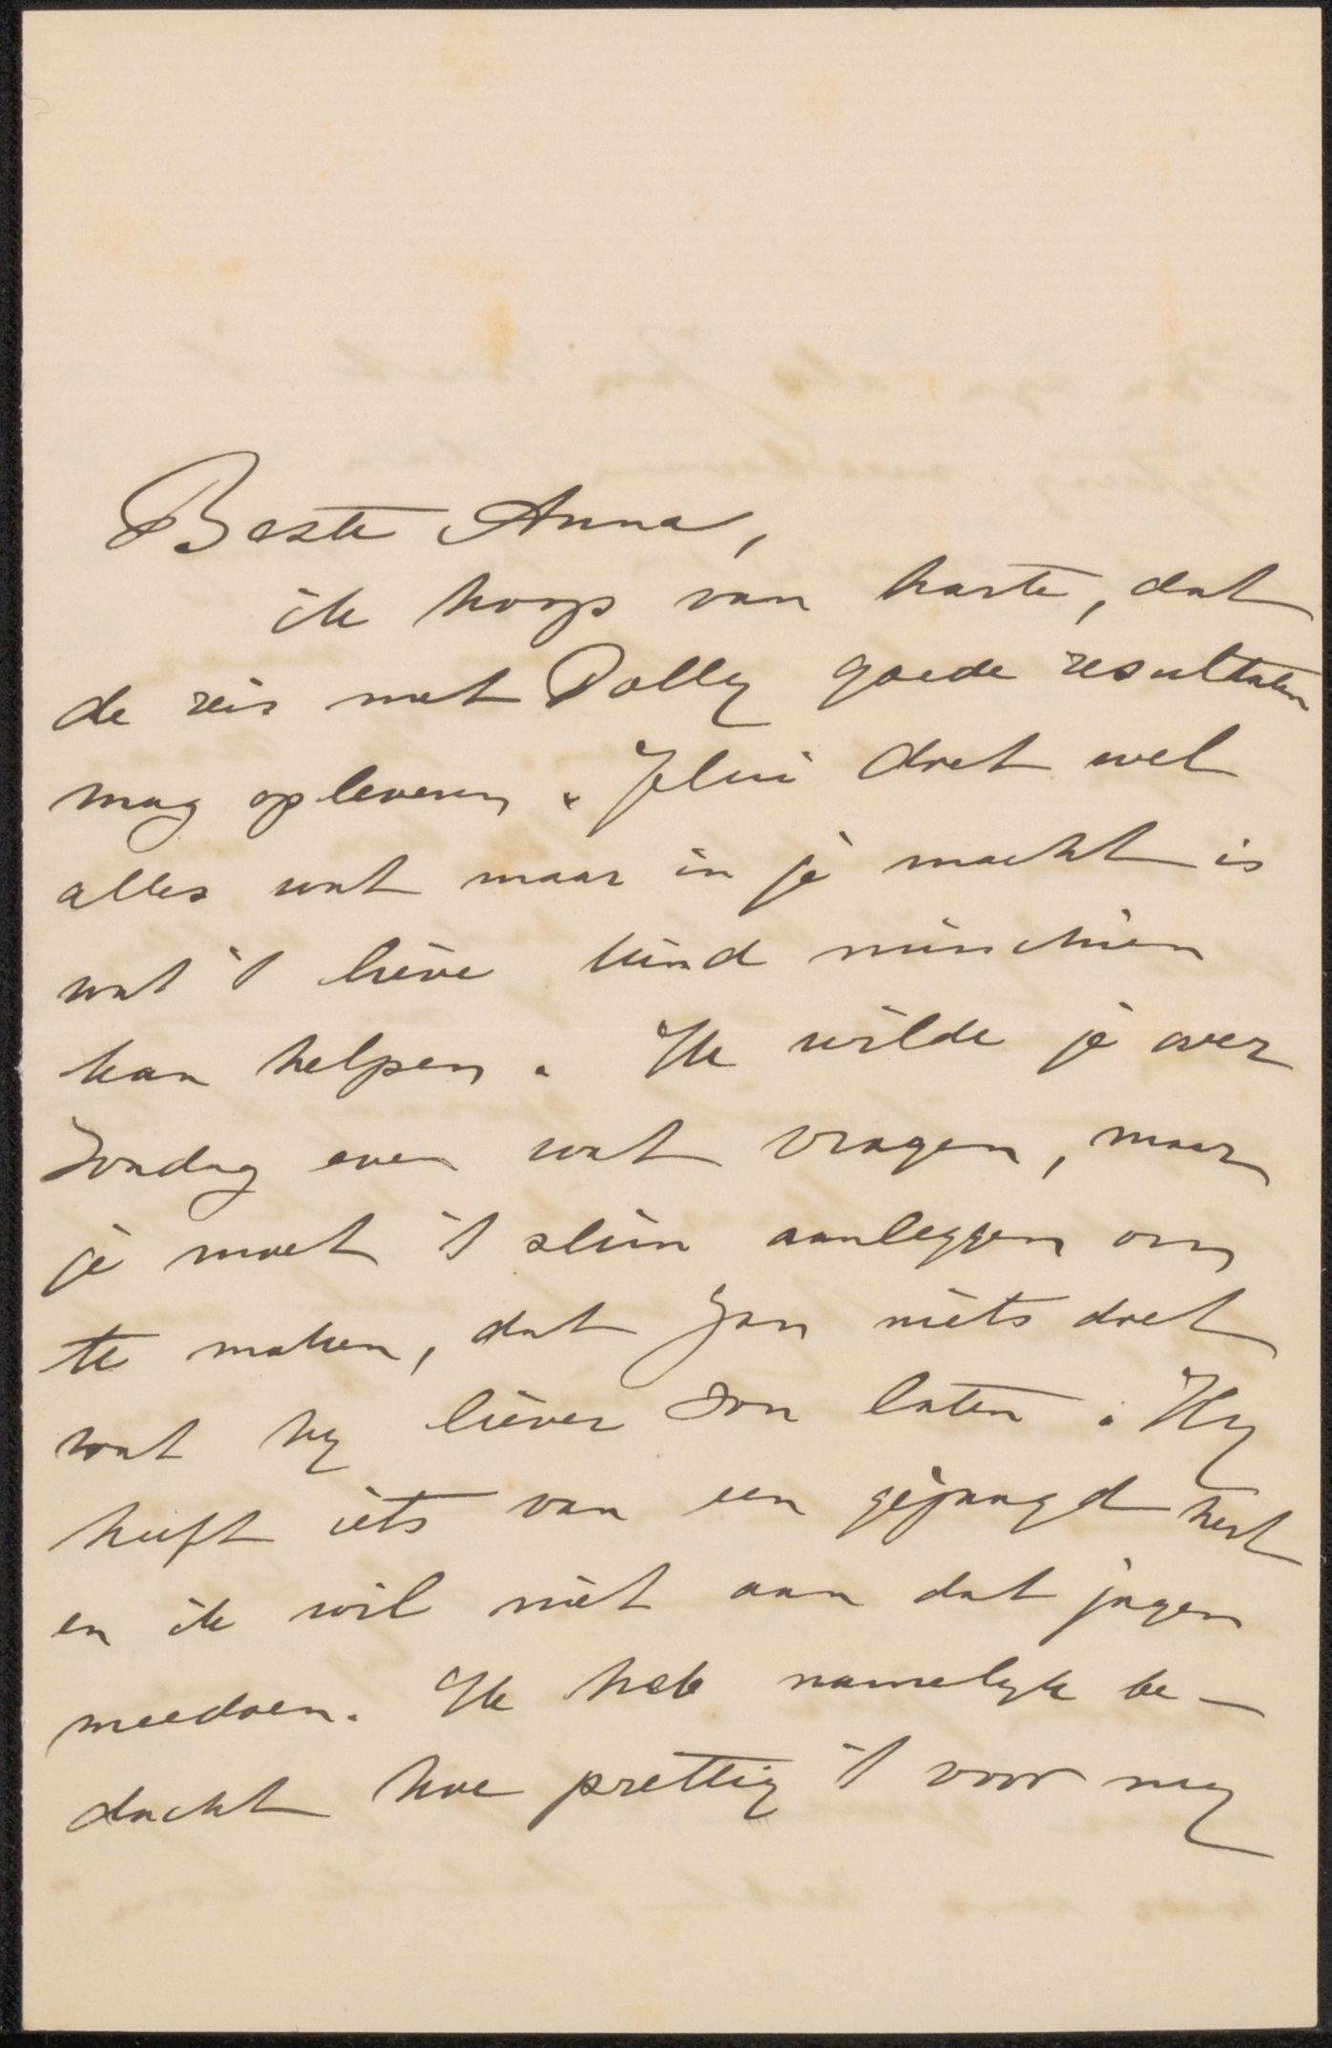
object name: letter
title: Brief aan Anna Dorothea Dirks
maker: wally moes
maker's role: draughtsman, print maker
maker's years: 1856-1918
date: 1903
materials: ink, paper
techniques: pen, writing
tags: painter, designer, jan veth, artist, anna dorothea dirks, family life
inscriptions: watermark, collector's mark: ‘RPK’